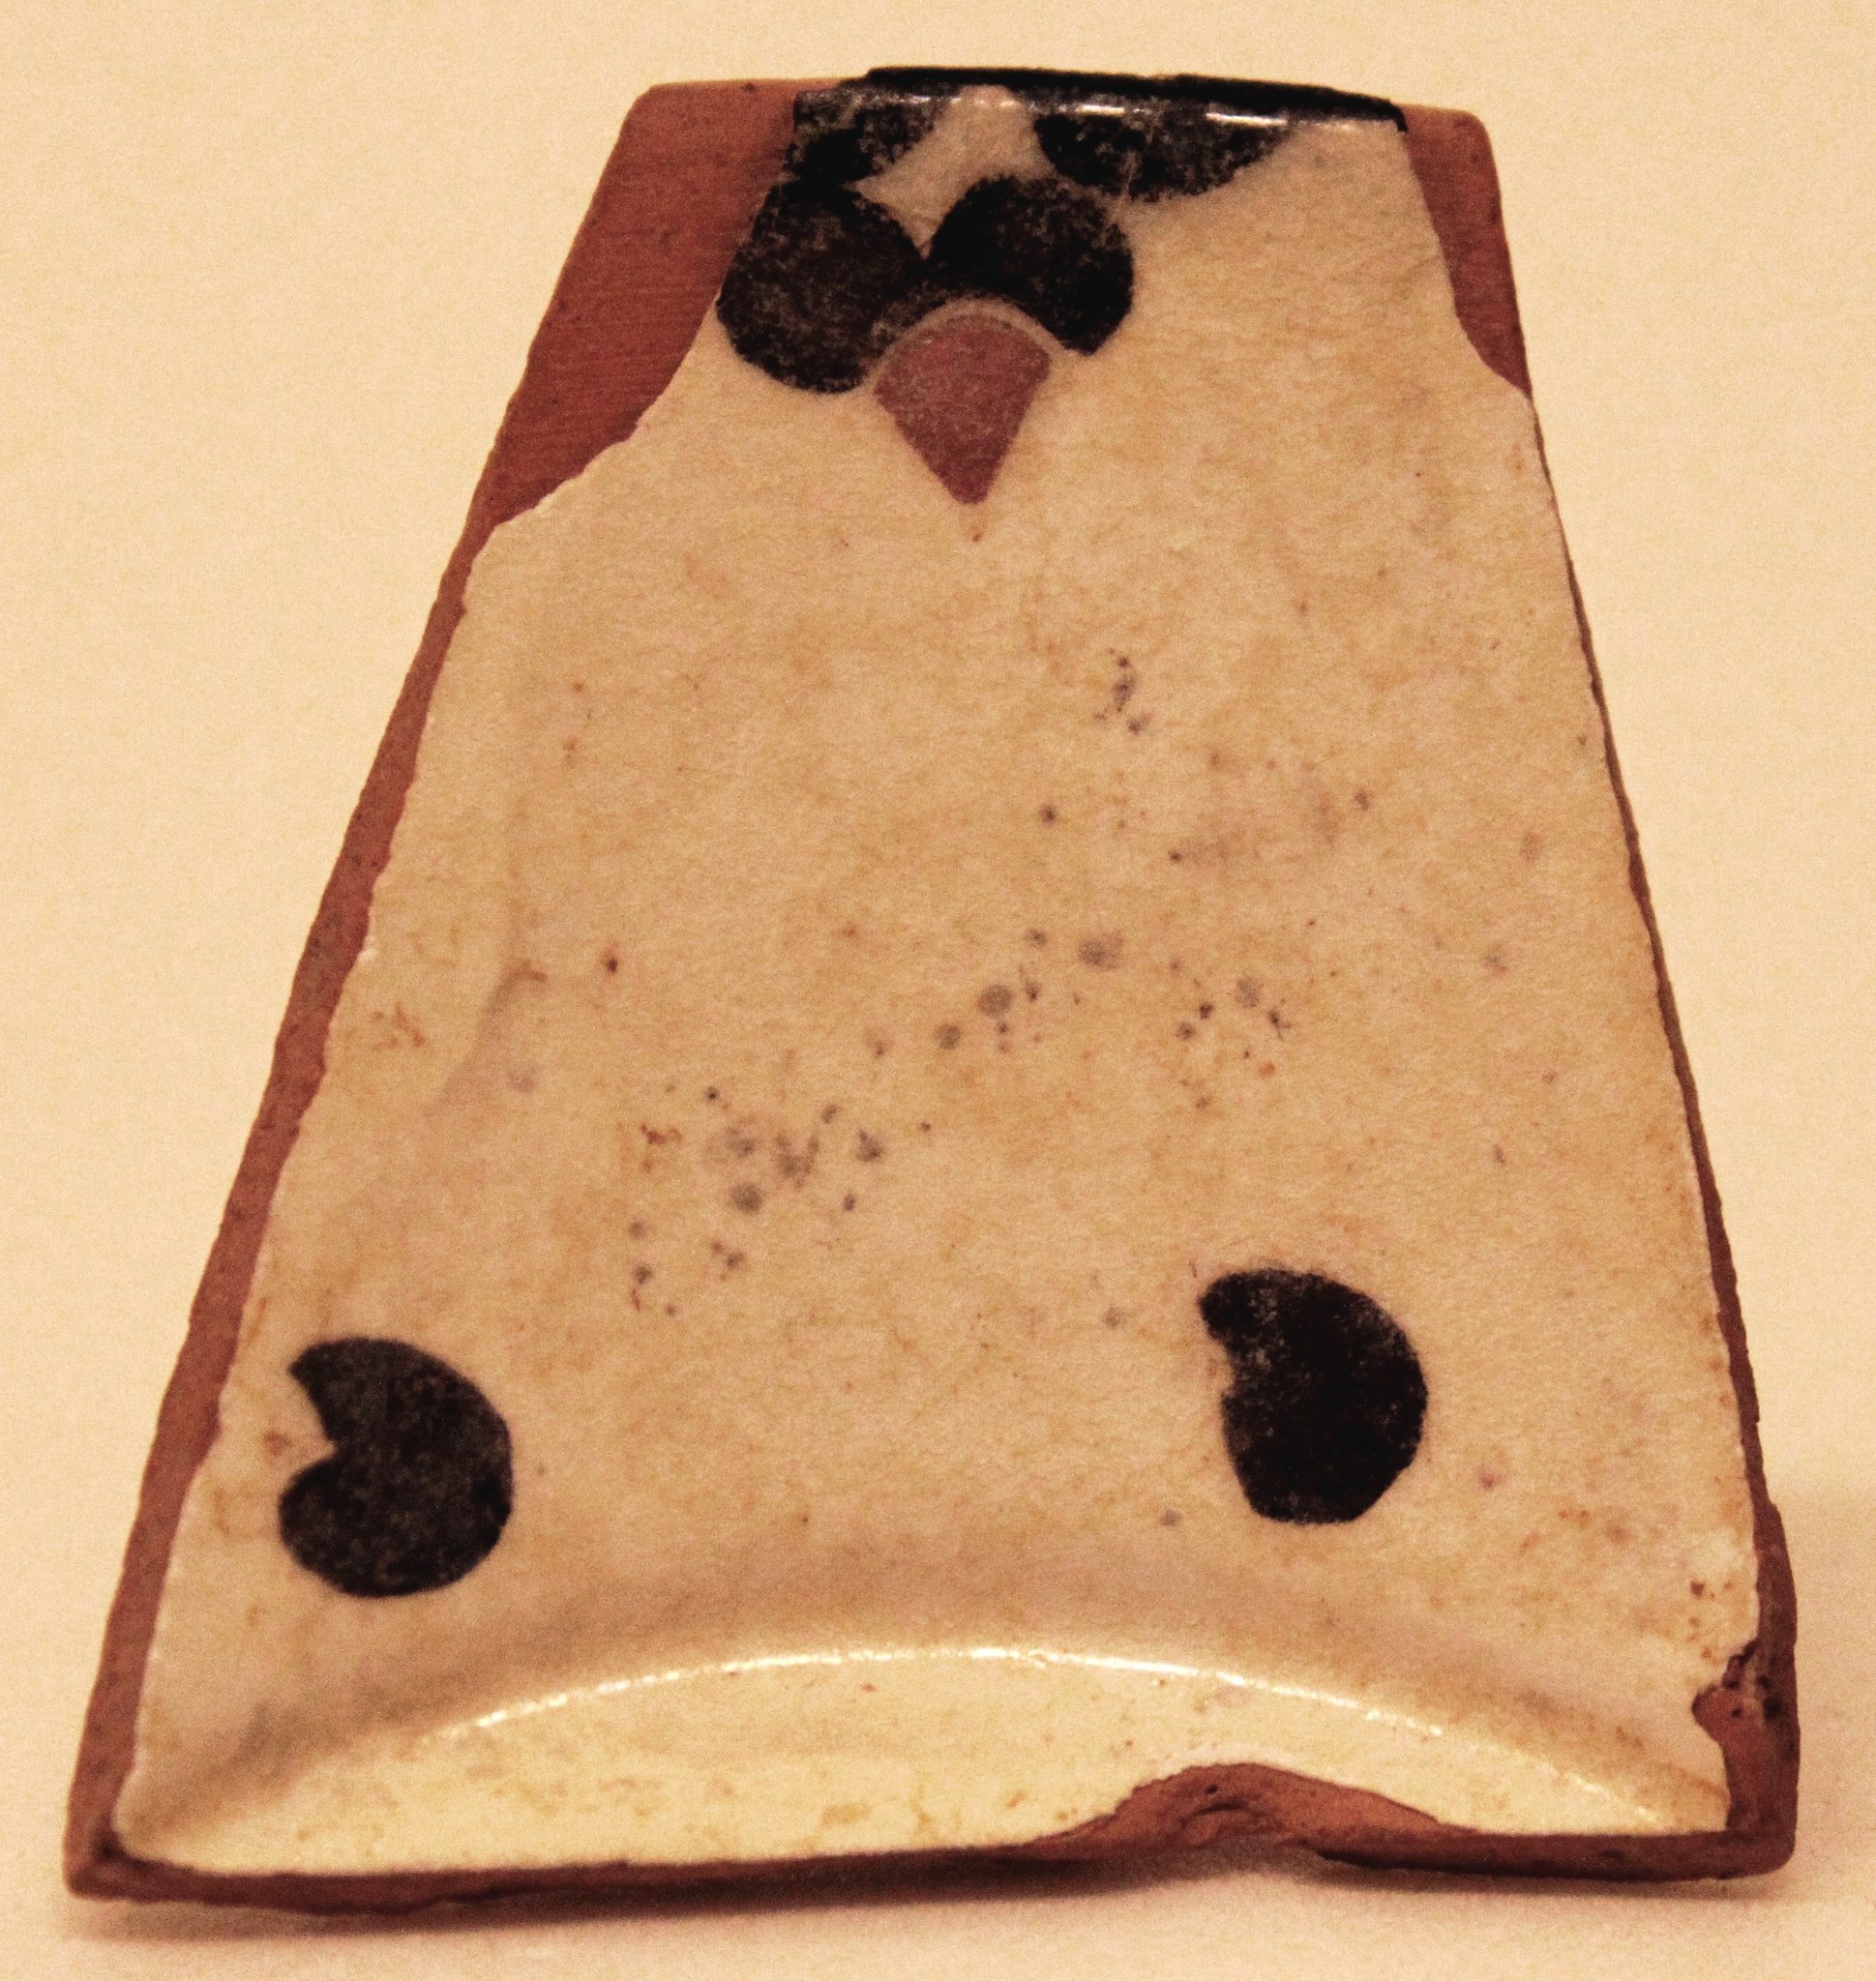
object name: fragment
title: Ceramic Fragment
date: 801-1000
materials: earthenware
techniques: painting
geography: iran